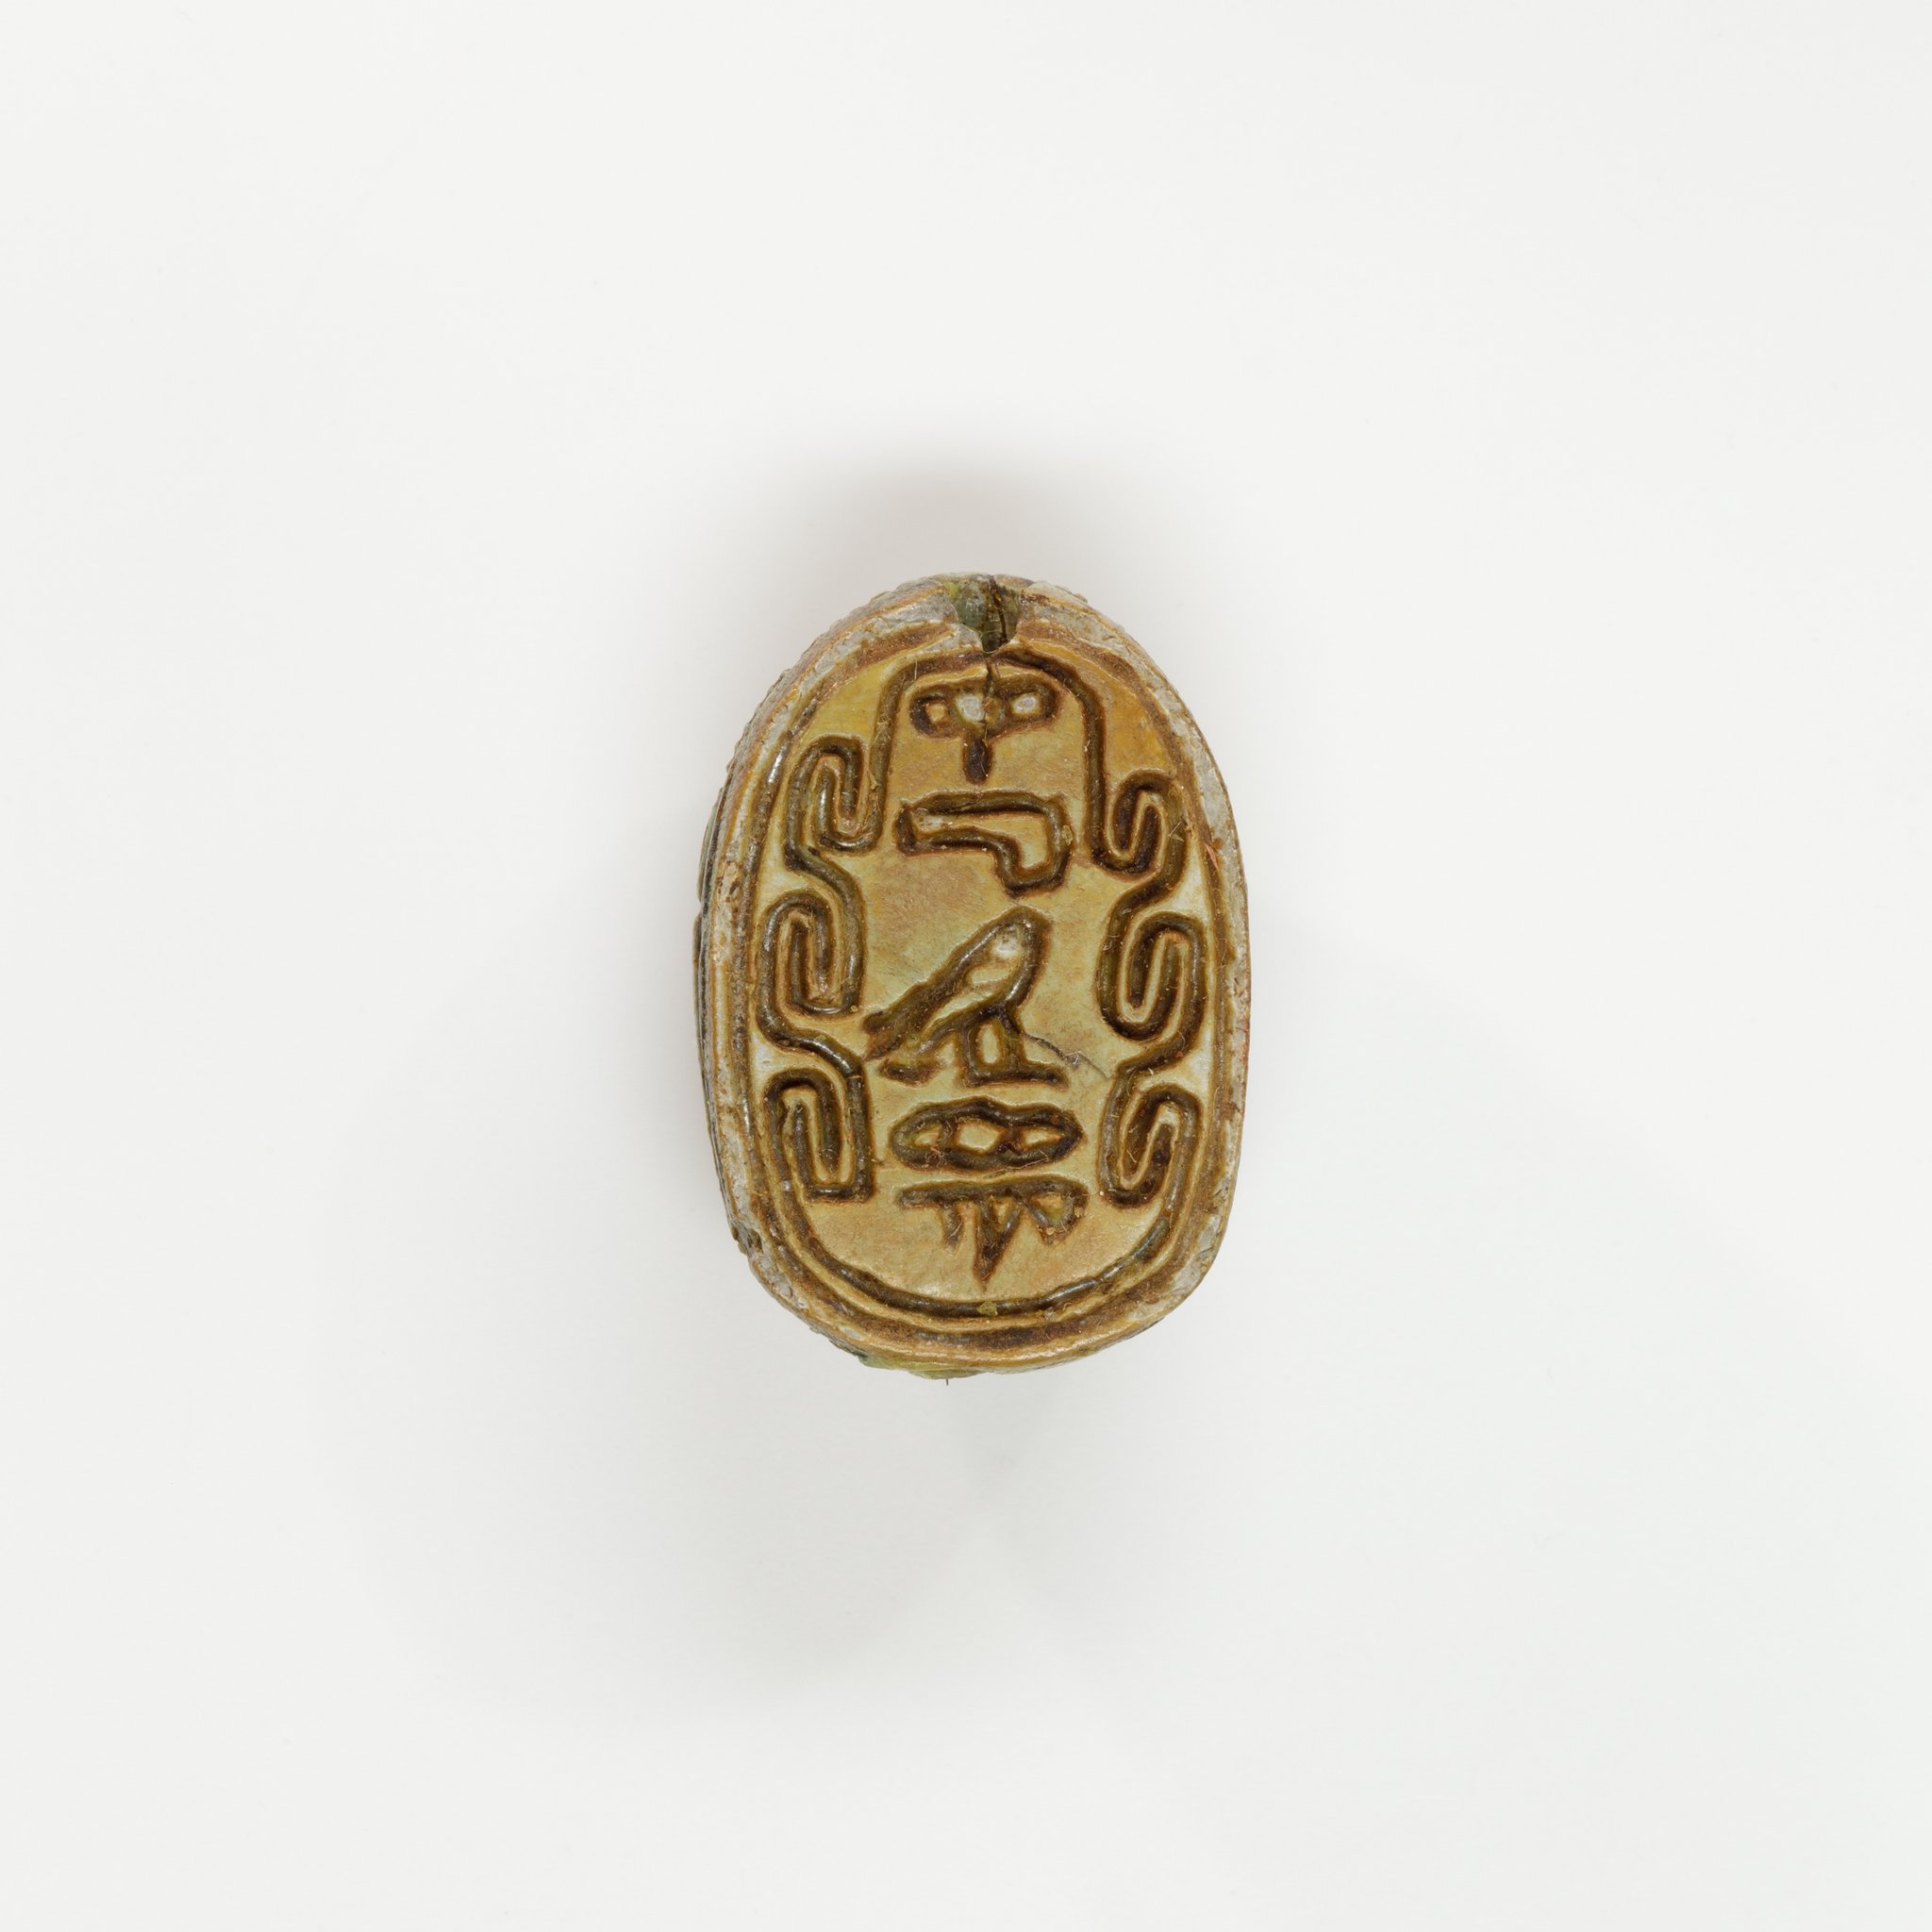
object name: scarab, harmin, min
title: Scarab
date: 1802-1640 BCE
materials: stone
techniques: glazing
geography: egypt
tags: hieroglyphs,scarabs